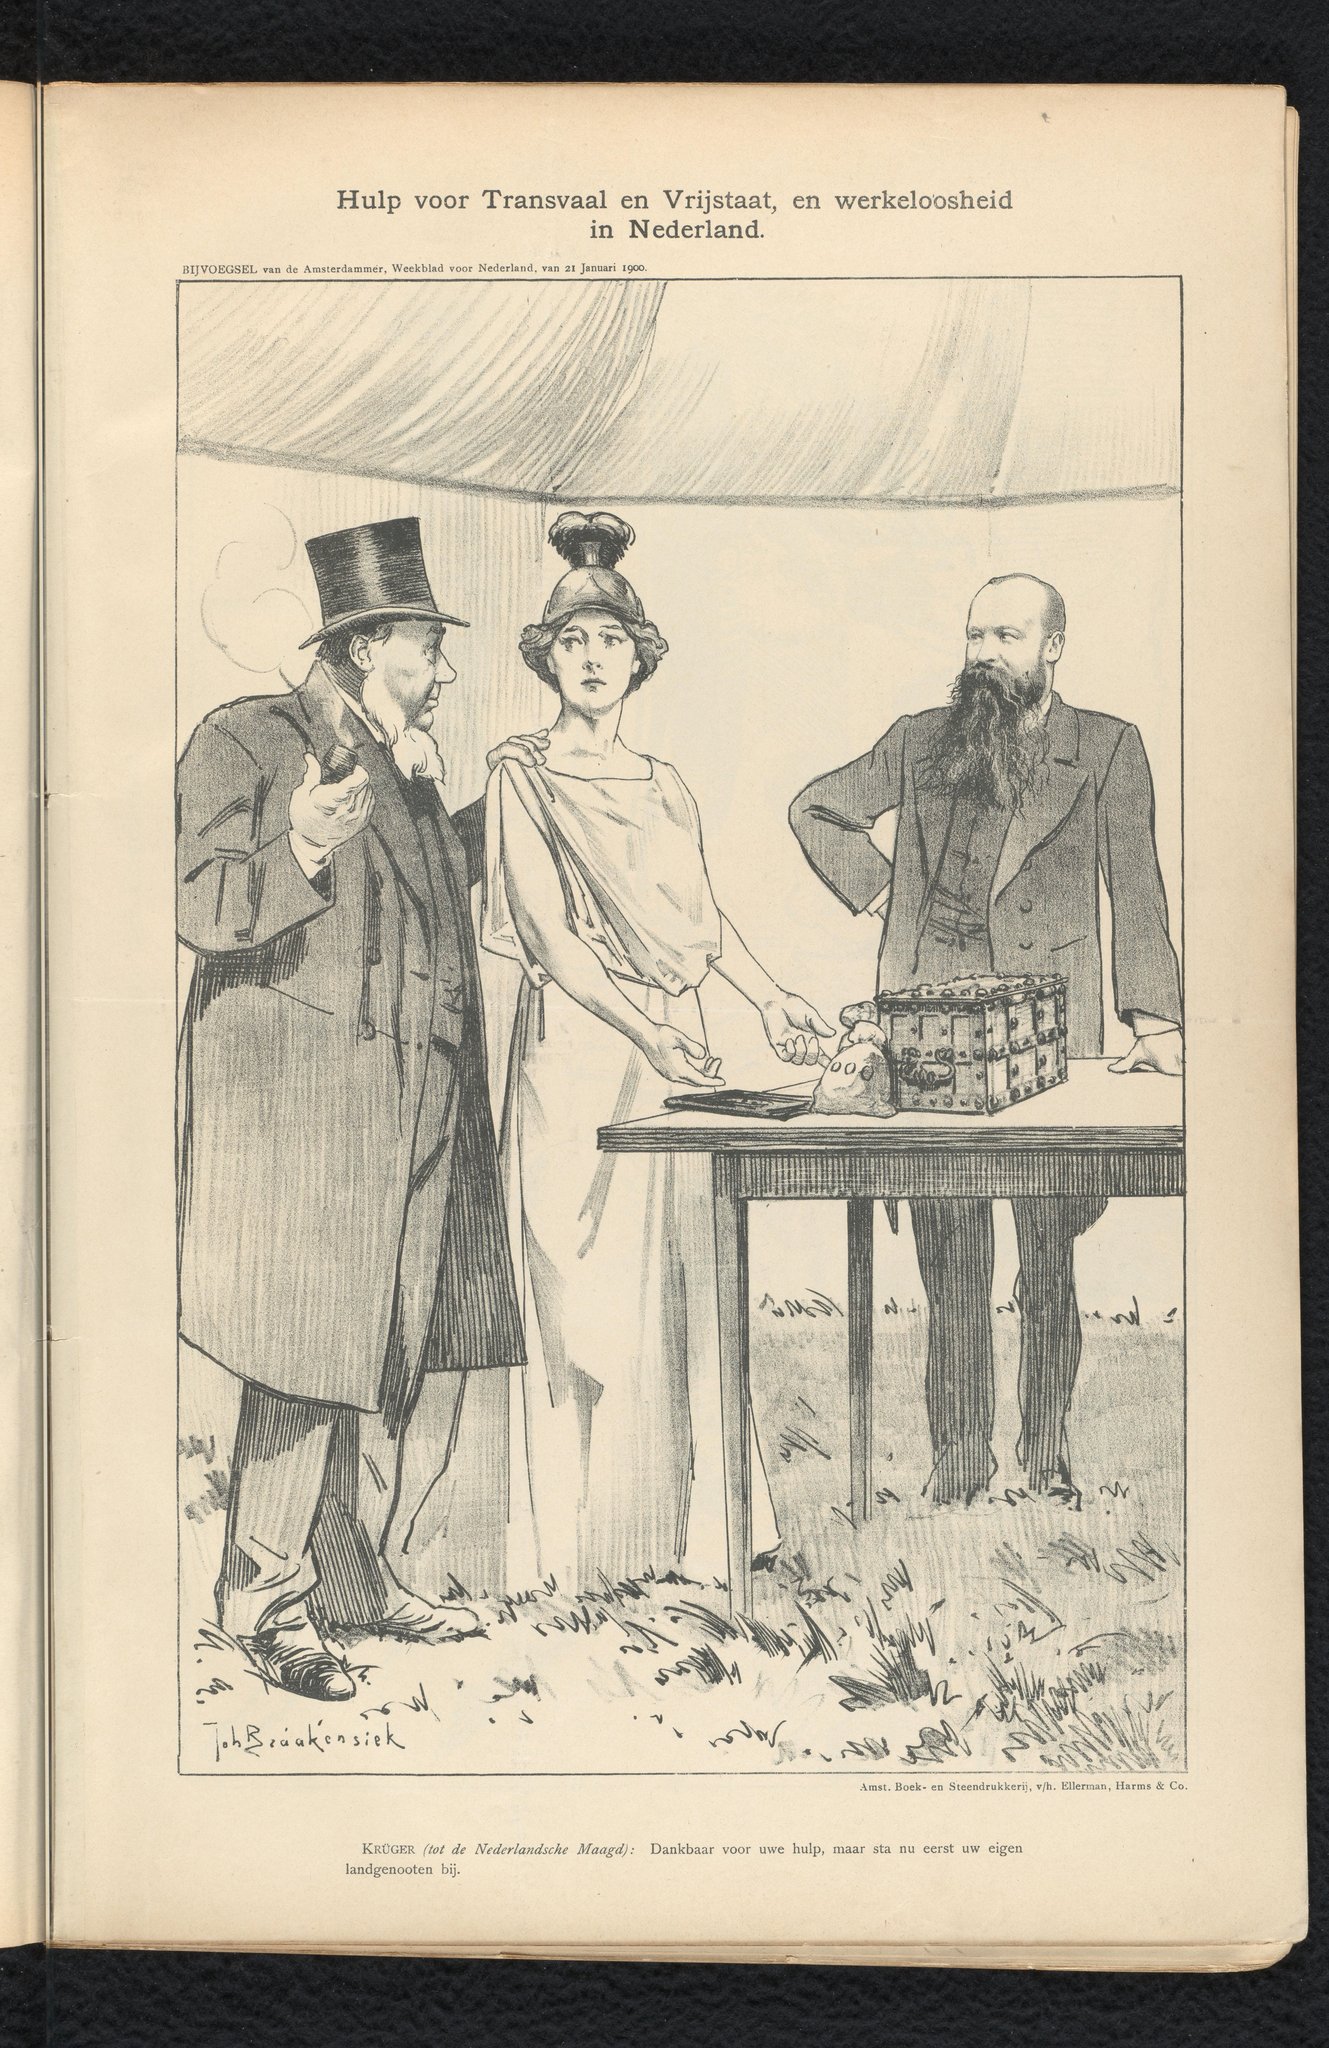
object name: cartoon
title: Hulp voor Transvaal en Vrijstaat, en werkeloosheid in Nederland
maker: johan braakensiek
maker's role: draughtsman, print maker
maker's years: 1858-1940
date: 1900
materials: paper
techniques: lithograph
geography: amsterdam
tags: politician, personifications of countries, nations, states, districts, etc., taxes and financial administration, political caricatures and satires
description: De Nederlandse maagd wil de strijd van de Zuid-Afrikaanse republieken financieel steunen maar wordt door Kruger erop gewezen dat zorg voor de landgenoten voor gaat. President Steyn kijkt toe.